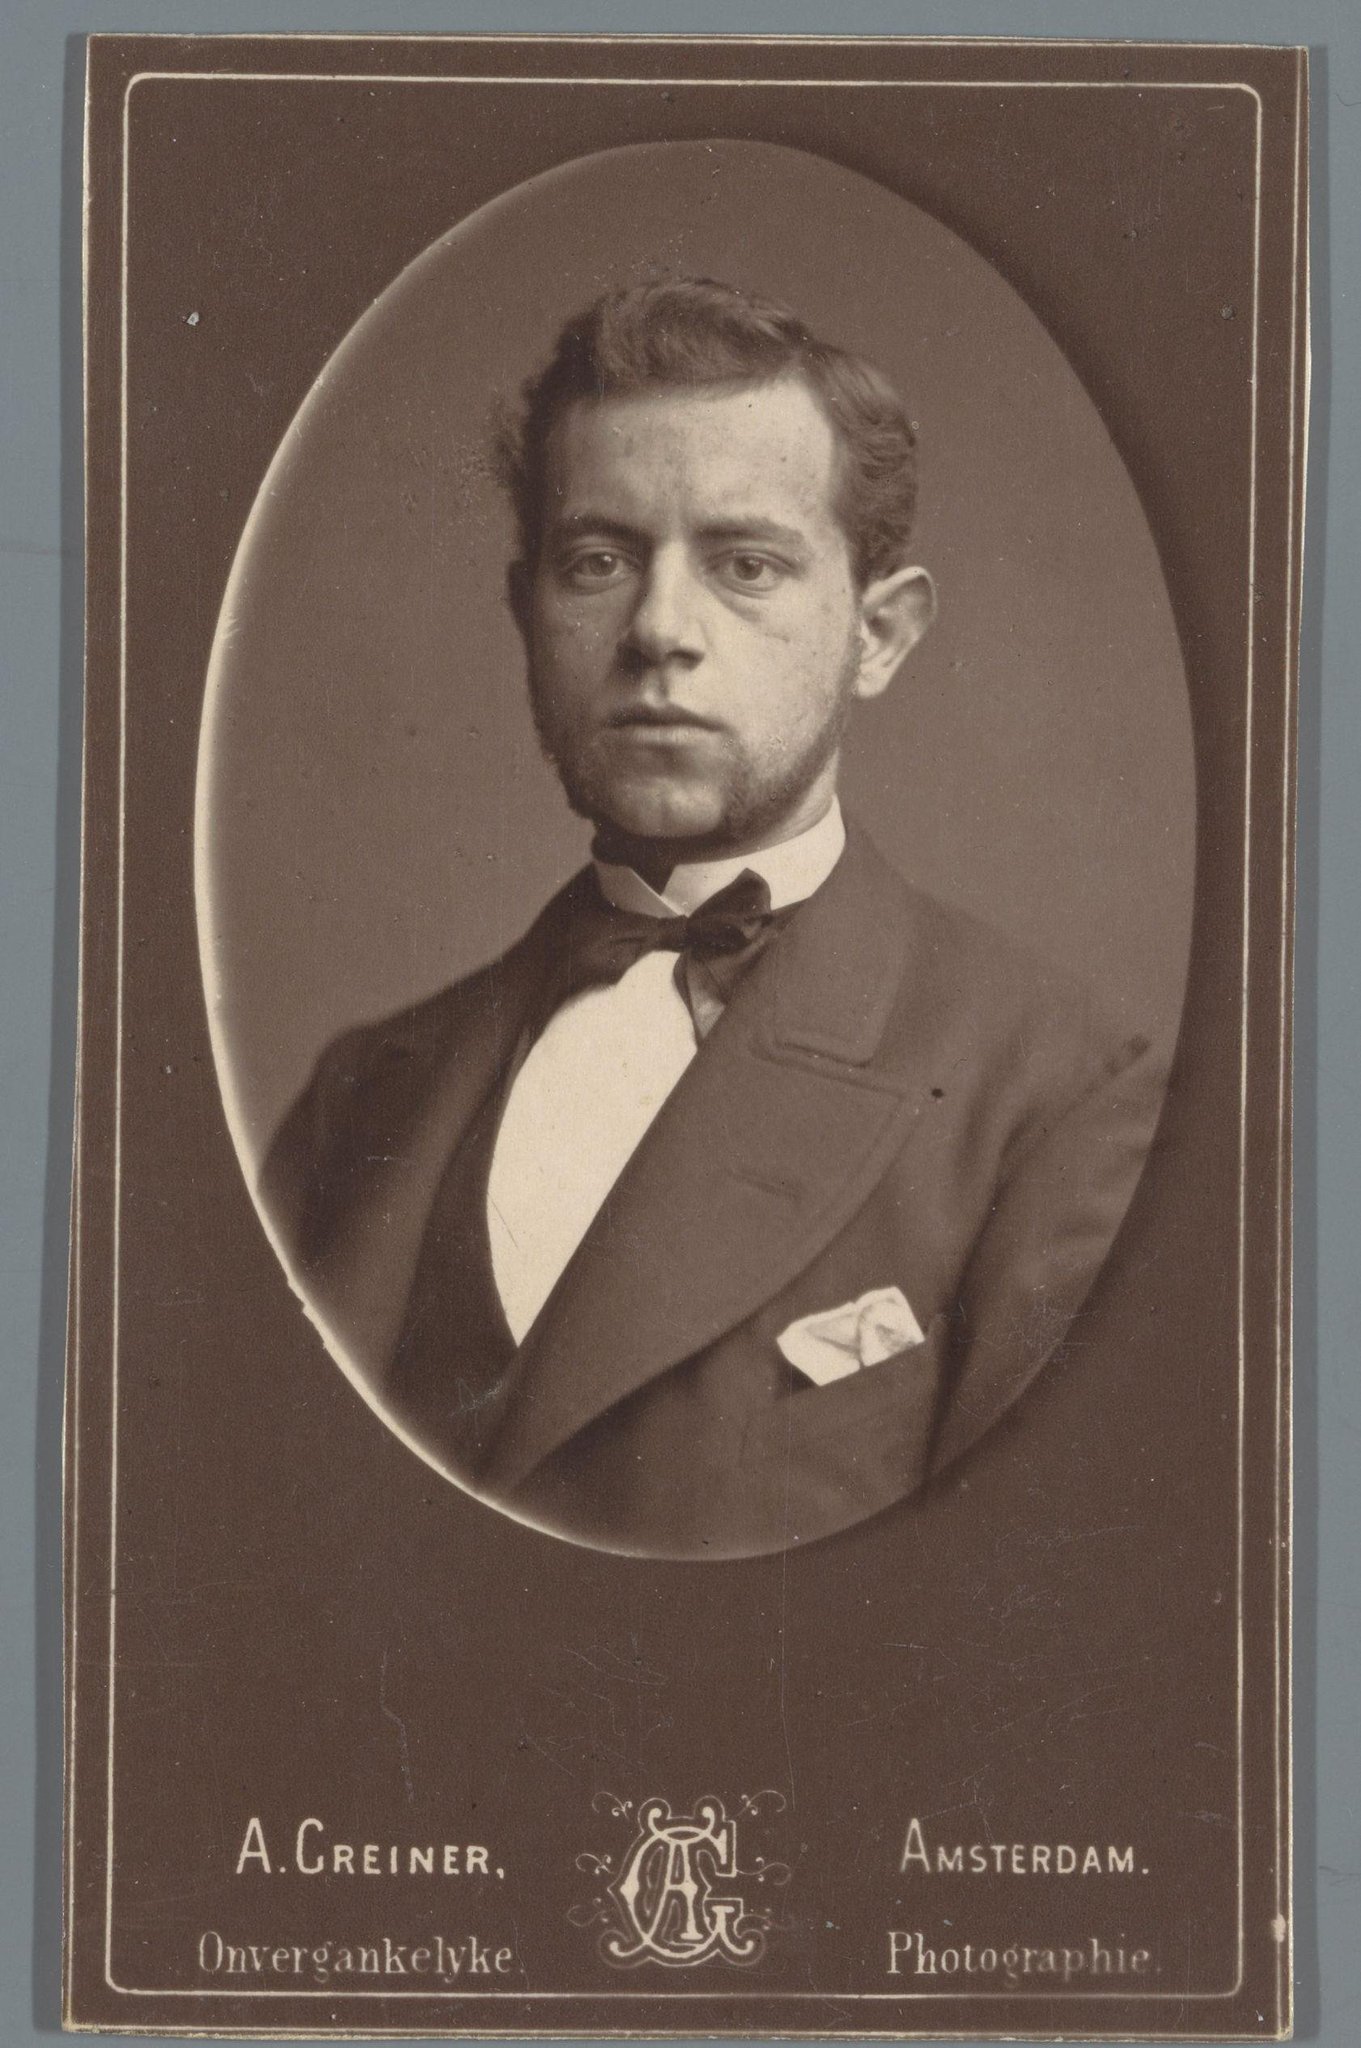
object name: carte de visite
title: Portret van een onbekende man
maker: albert greiner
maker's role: fotograaf, fotostudio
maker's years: 1833-1890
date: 1861-1874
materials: cardboard, photographic support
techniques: carbon print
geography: amsterdam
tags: adult man, historical persons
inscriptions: inscription: ‘AG/ A. GREINER AMSTERDAM./ Onvergankelyke Photographie’, inscription: ‘Kooldruk’